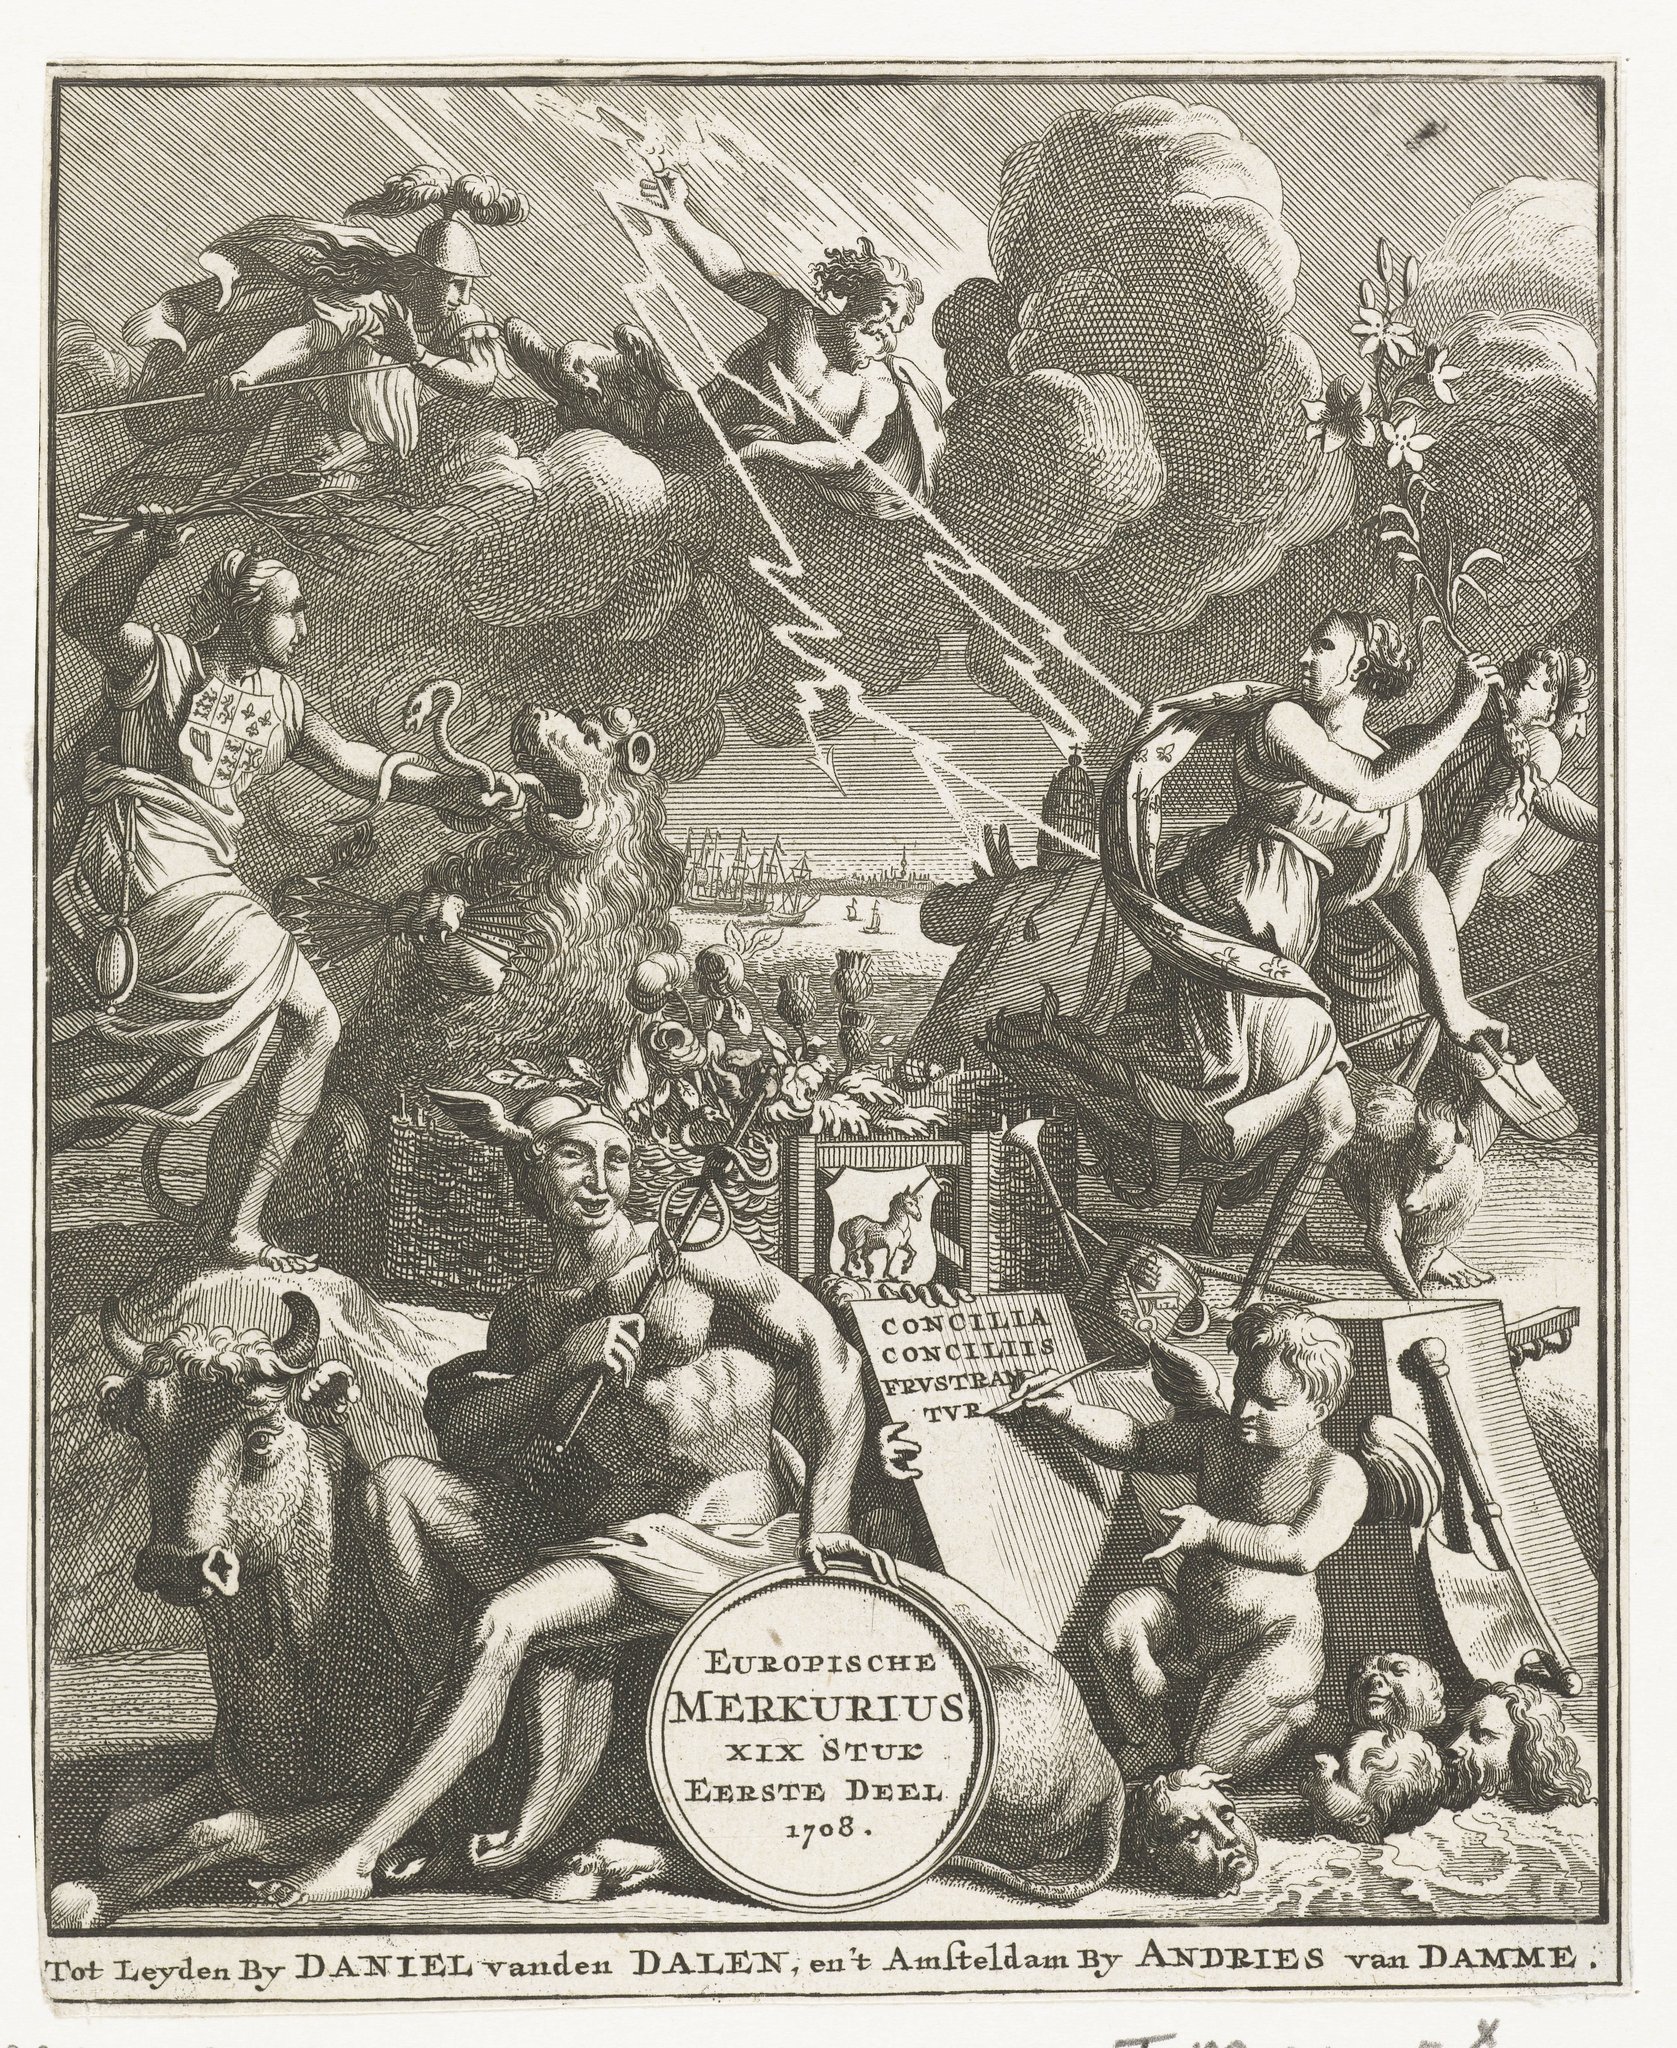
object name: print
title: Titelpagina voor de Europische Mercurius voor het jaar 1708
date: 1708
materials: paper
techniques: engraving, etching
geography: northern netherlands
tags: specific aspects, allegorical aspects of mercury; mercury as patron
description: Titelpagina voor de Europische Mercurius, dl. XIX, eerste deel van 1708. Op de voorgrond de lachende Mercurius, Jupiter verjaagt Frankrijk met bliksemschichten. Links de Nederlandse Leeuw bij de Engelse Tuin, vechtend met de Britse Maagd die een masker van bedrog draagt.